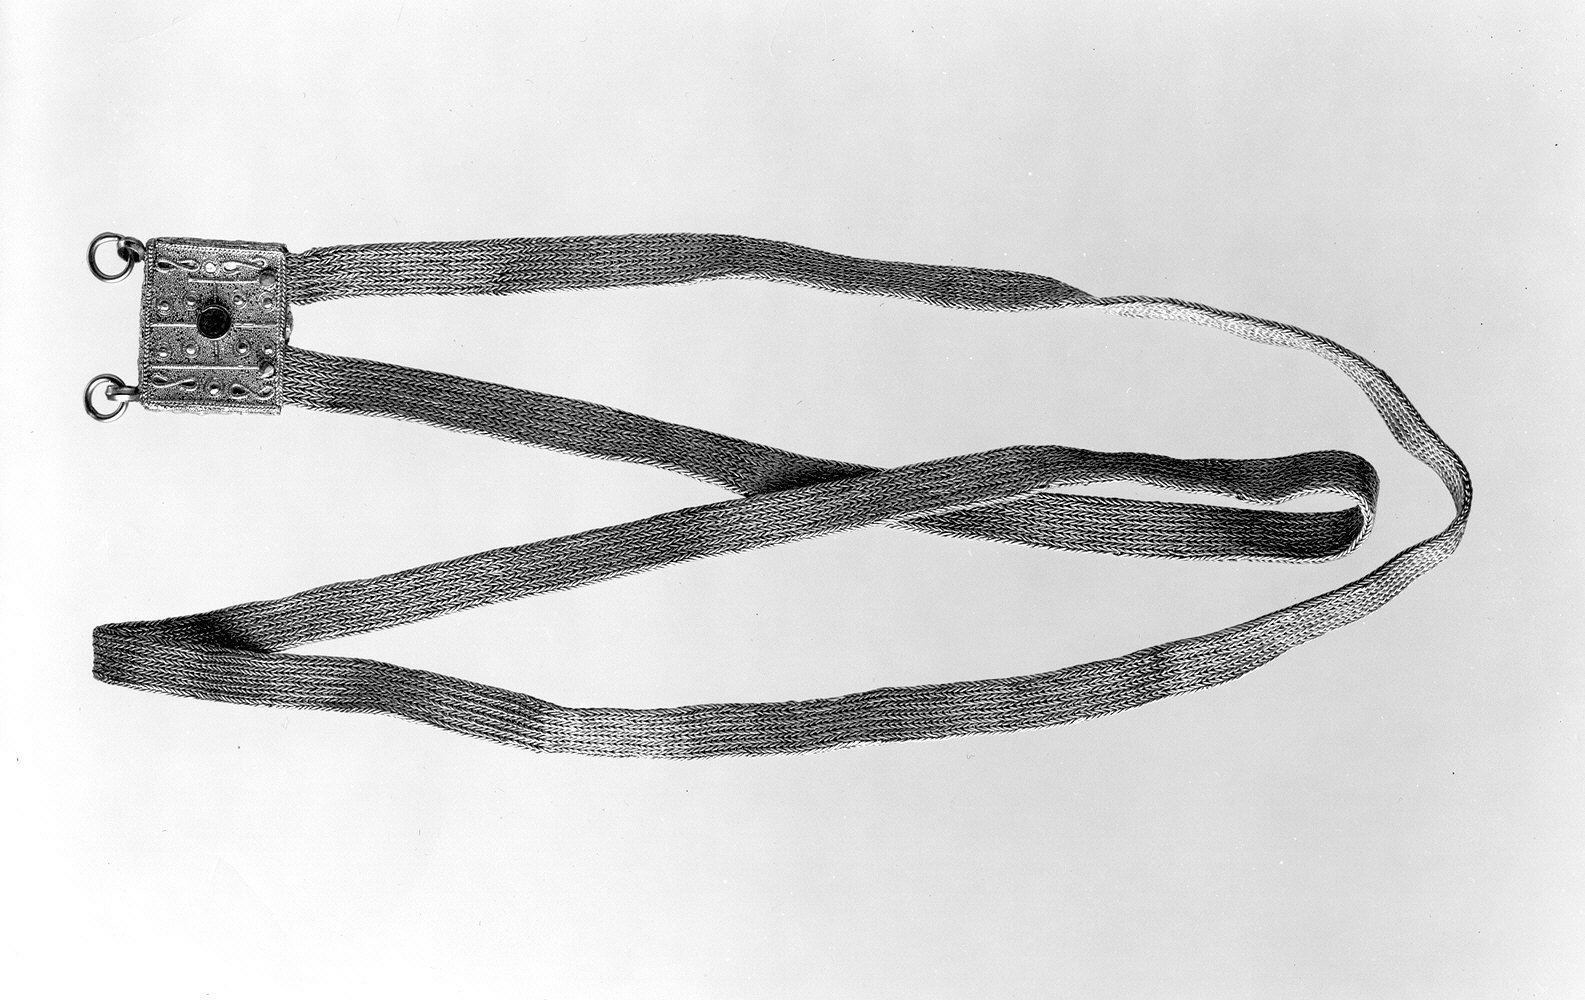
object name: strap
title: Woven strap with a pendant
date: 500-301 BCE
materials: amber, gold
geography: iberian peninsula